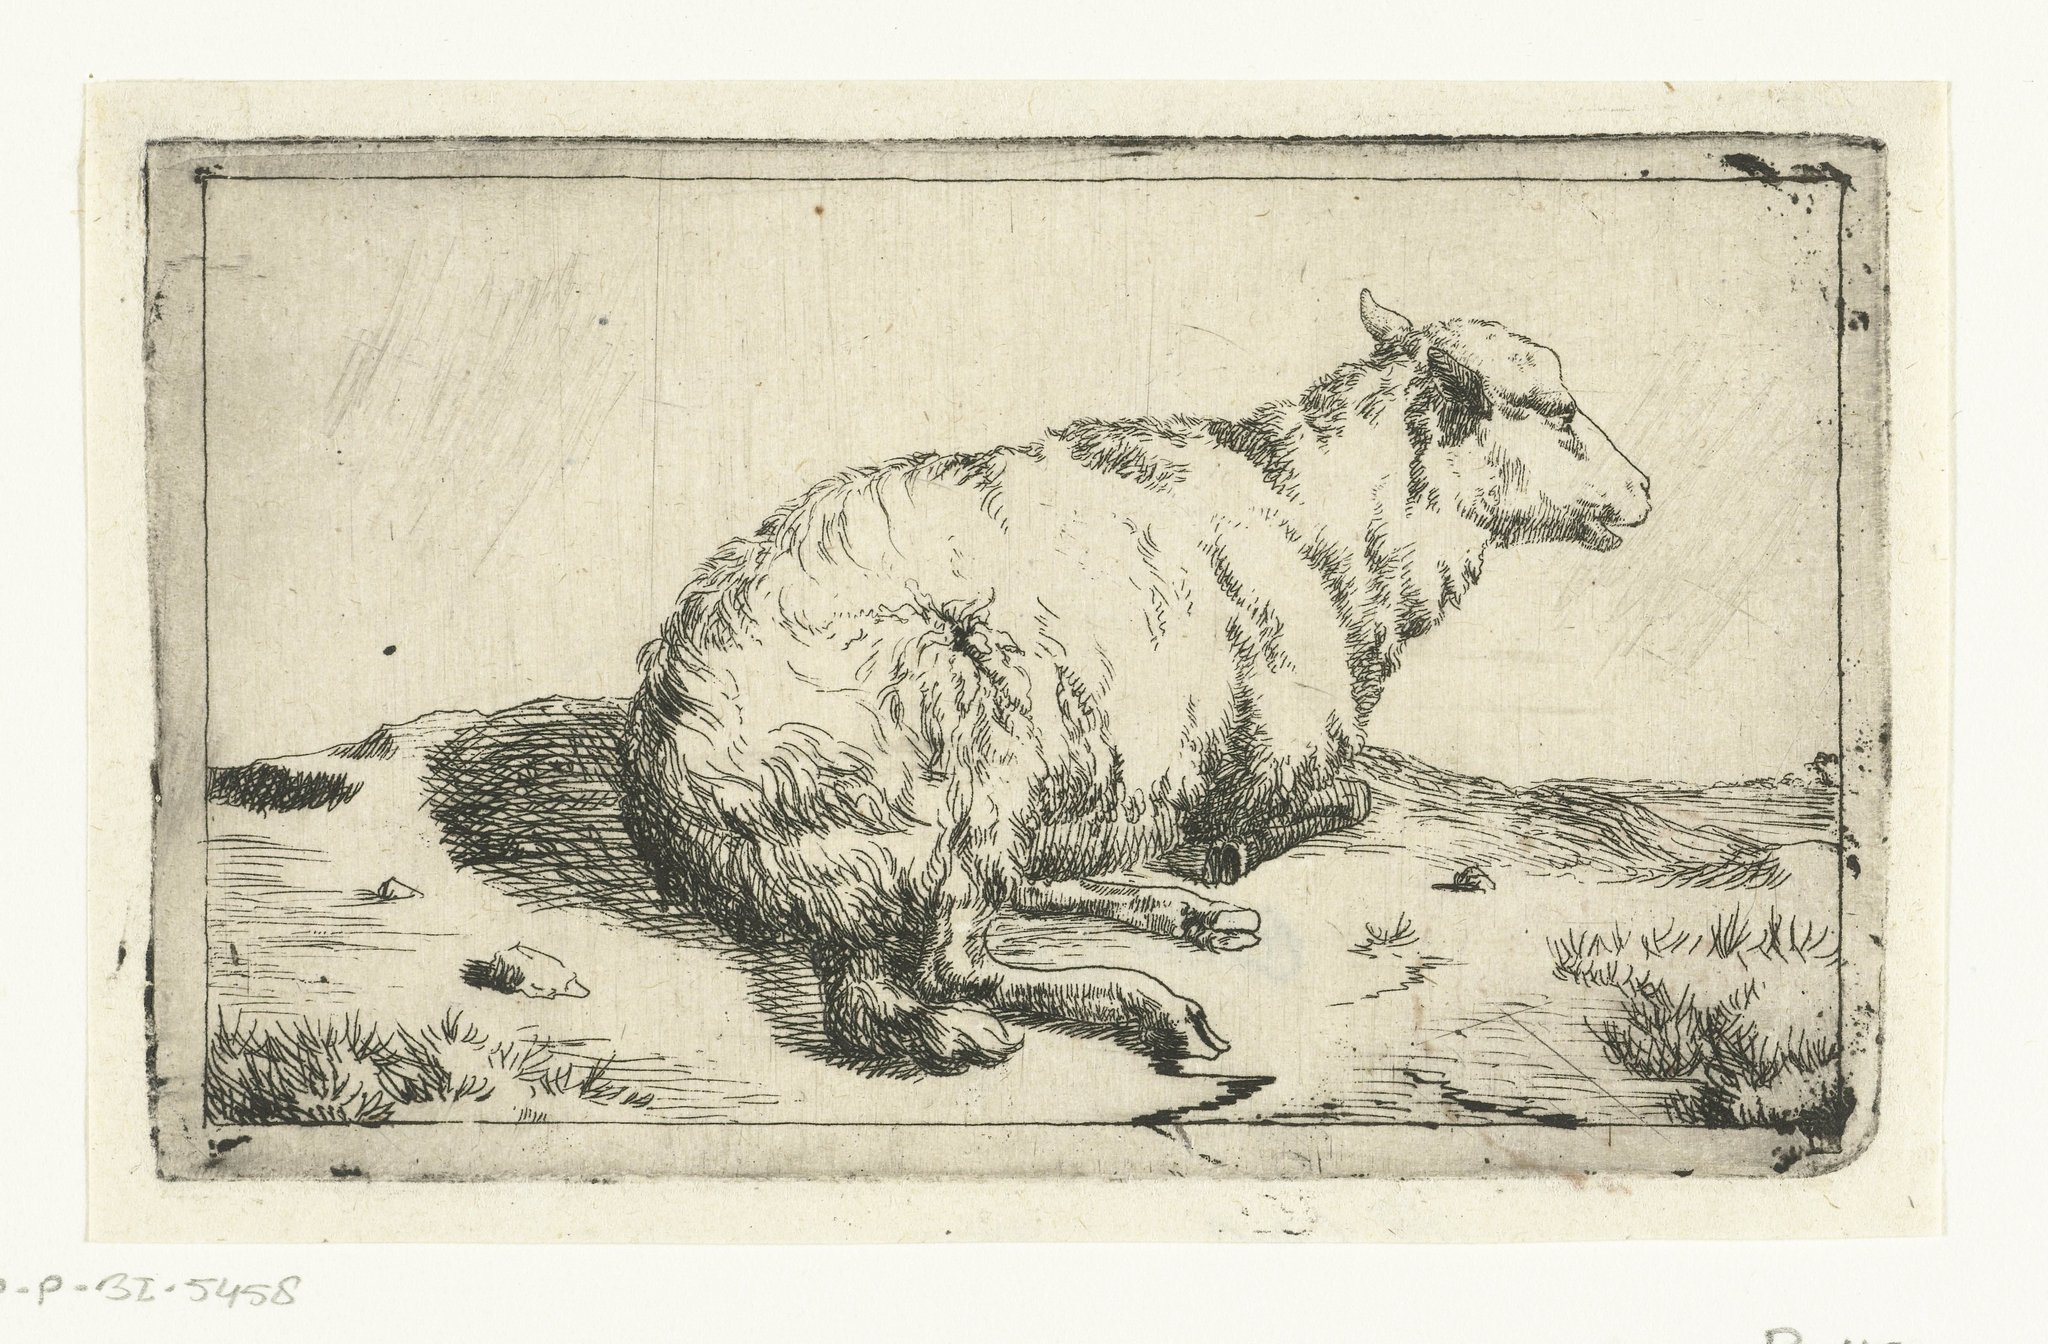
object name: print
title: Rustend schaap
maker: marcus de bye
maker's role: print maker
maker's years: 1639-1688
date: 1657-1688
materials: paper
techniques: etching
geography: the hague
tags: sheep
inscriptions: collector's mark: Lugt 240